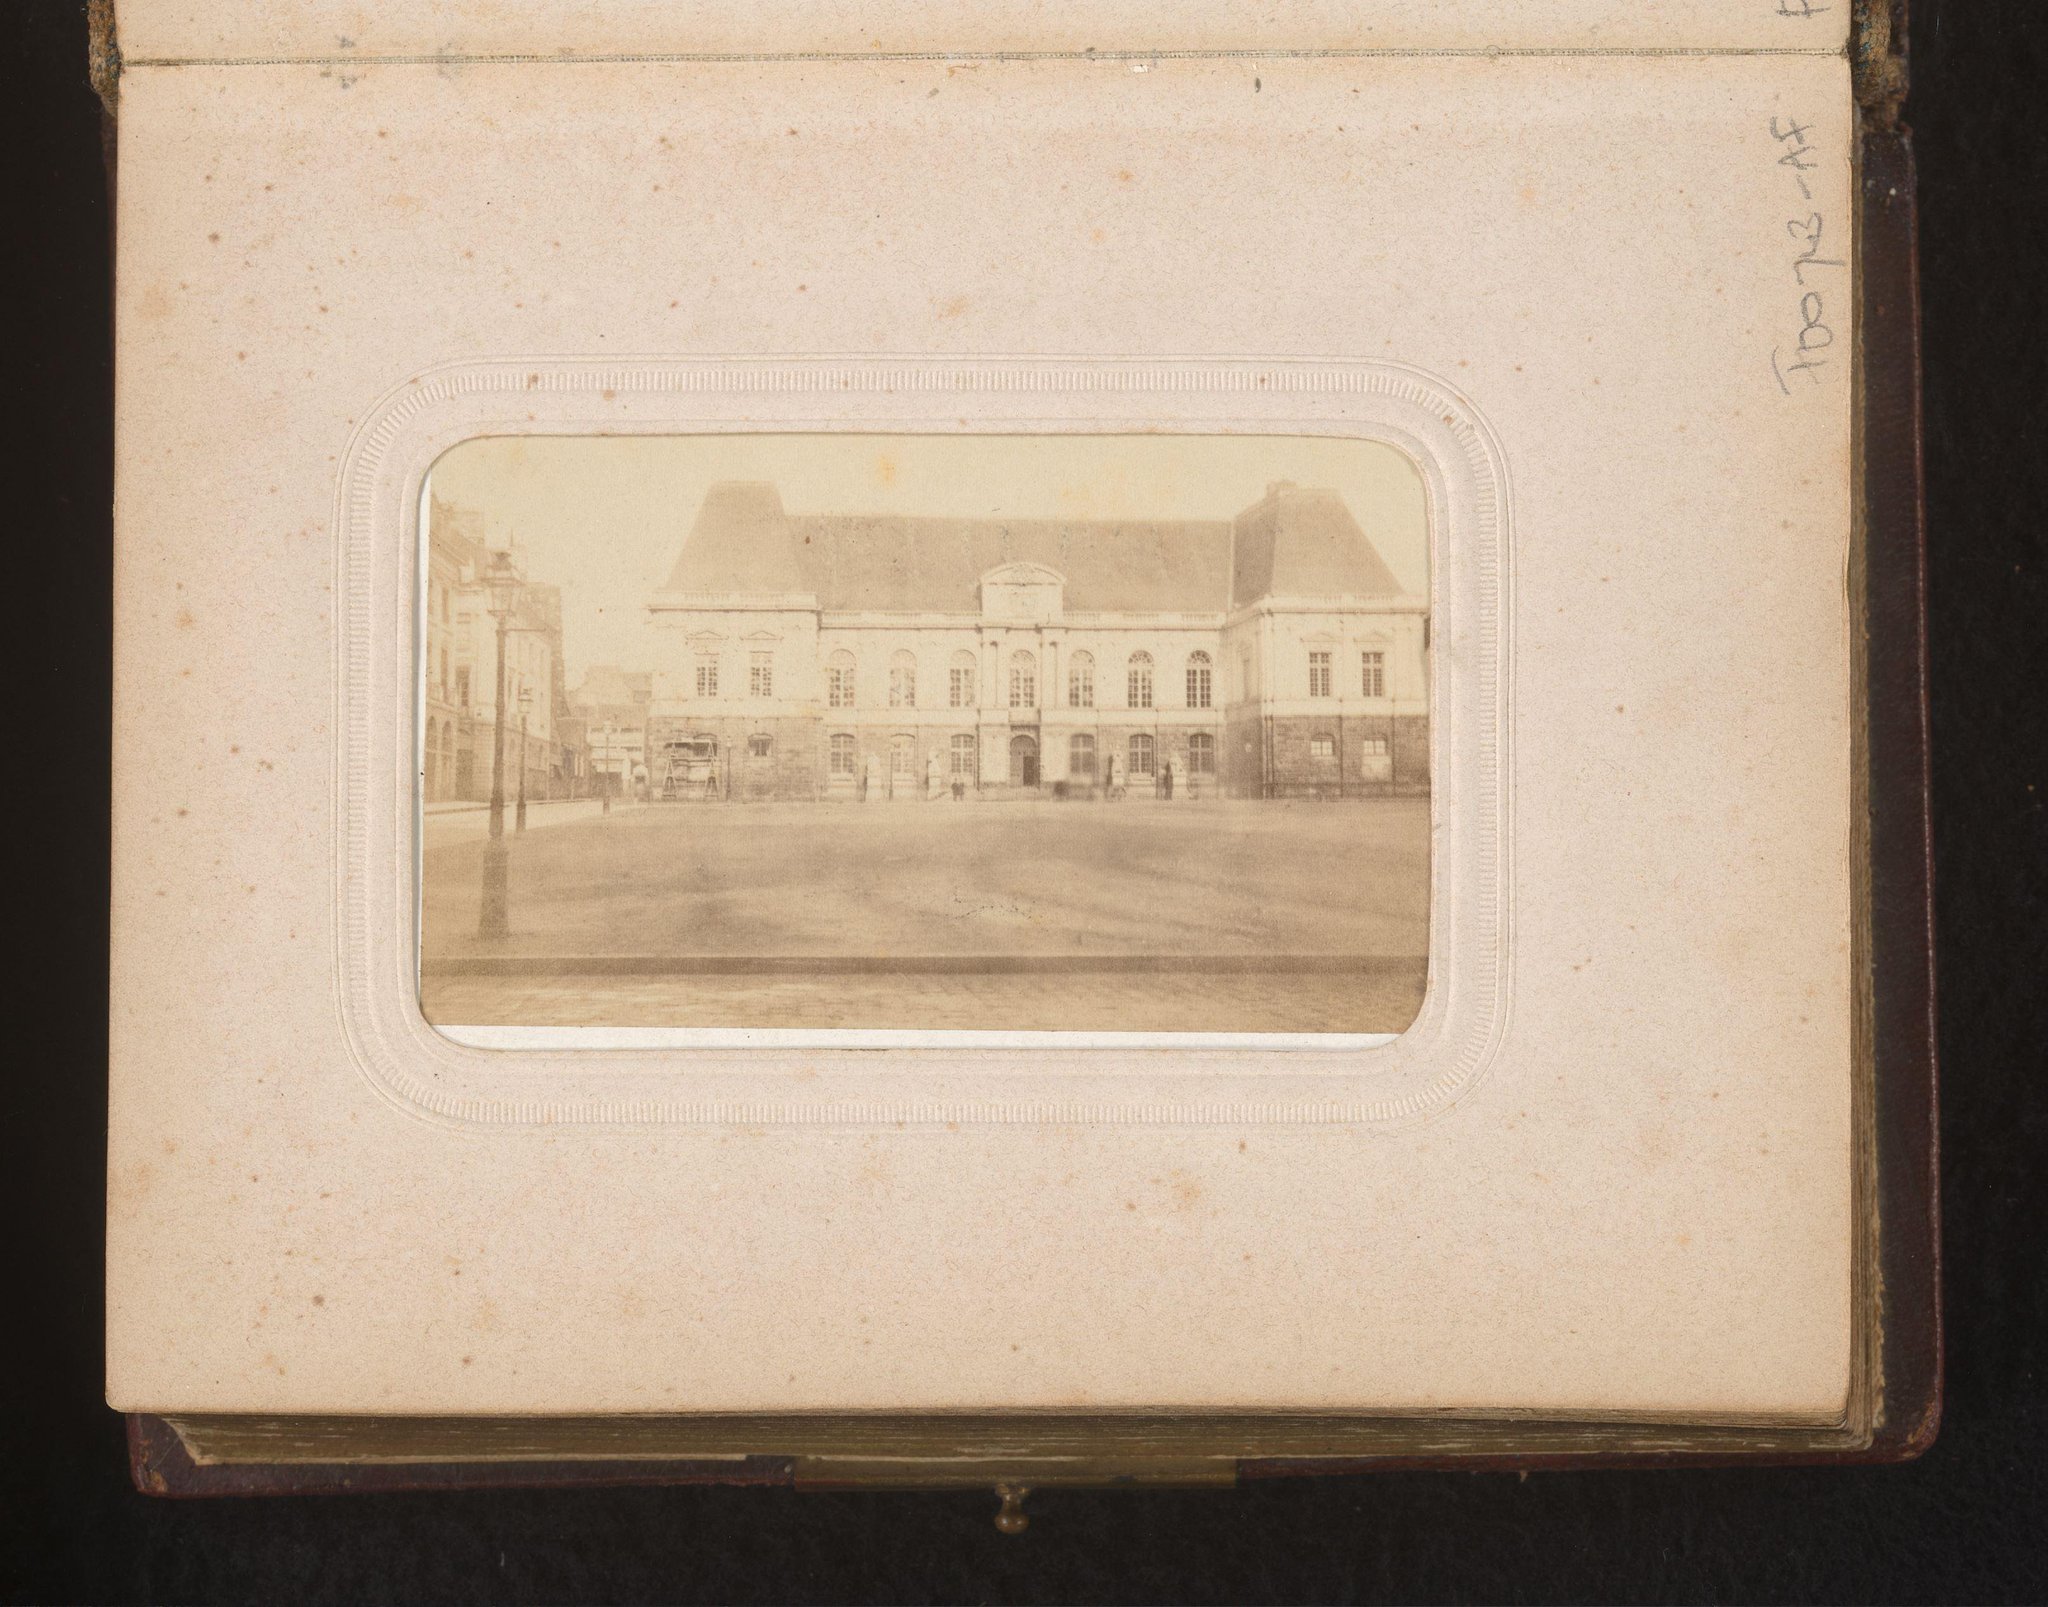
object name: carte de visite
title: Gezicht op een gebouw in Bretagne, Frankrijk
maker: h. chala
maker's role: fotograaf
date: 1860-1900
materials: cardboard, photographic support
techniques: albumen print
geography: brittany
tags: civic architecture; edifices; dwellings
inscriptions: inscription: ‘la Bretagne Pittoresque et Monumental/ photographiée par H. CHALA, élève de PIERRE PETIT./ PUBLICATION DE LA/ Librairie-Papeterie Générale de l'Ouest/ Place de la Mairie et Rue d'Orléans, 6./ RENNES.’